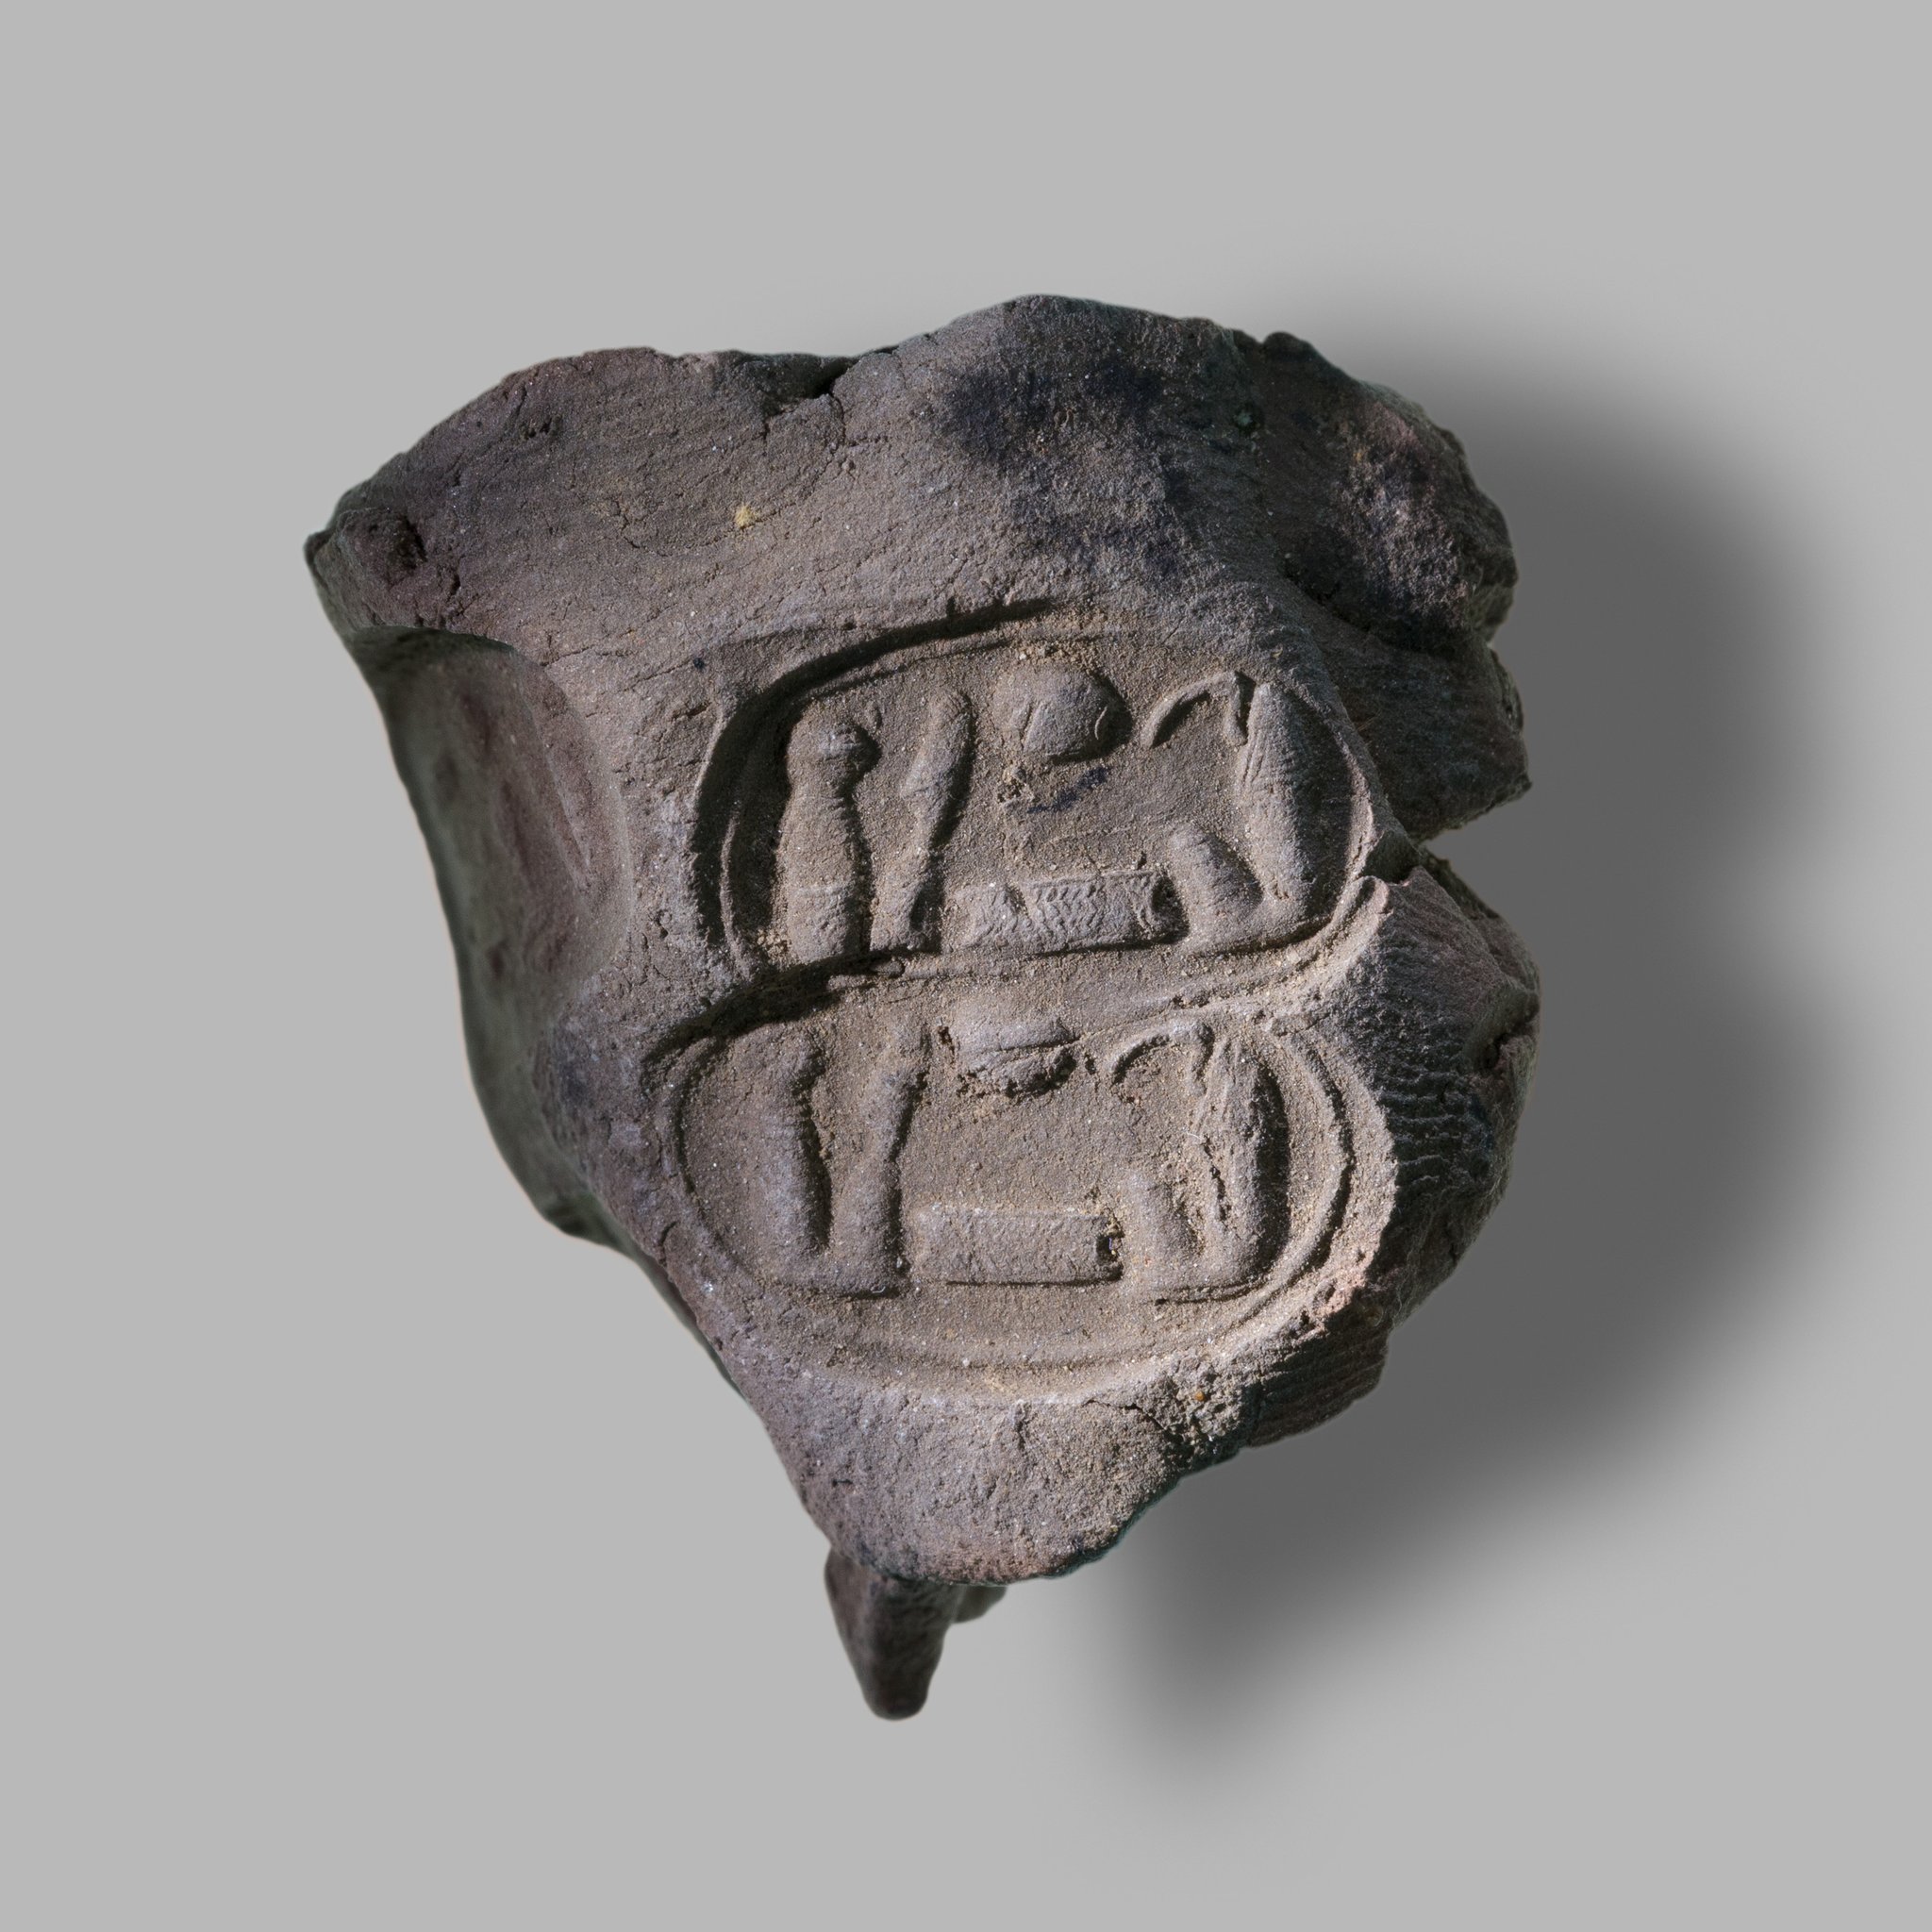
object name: sealing, amenhotep iii, nebmaatre, horus, onuris, re, thoth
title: Document Sealing With Multiple Seal Impressions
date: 1390-1352 BCE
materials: mud